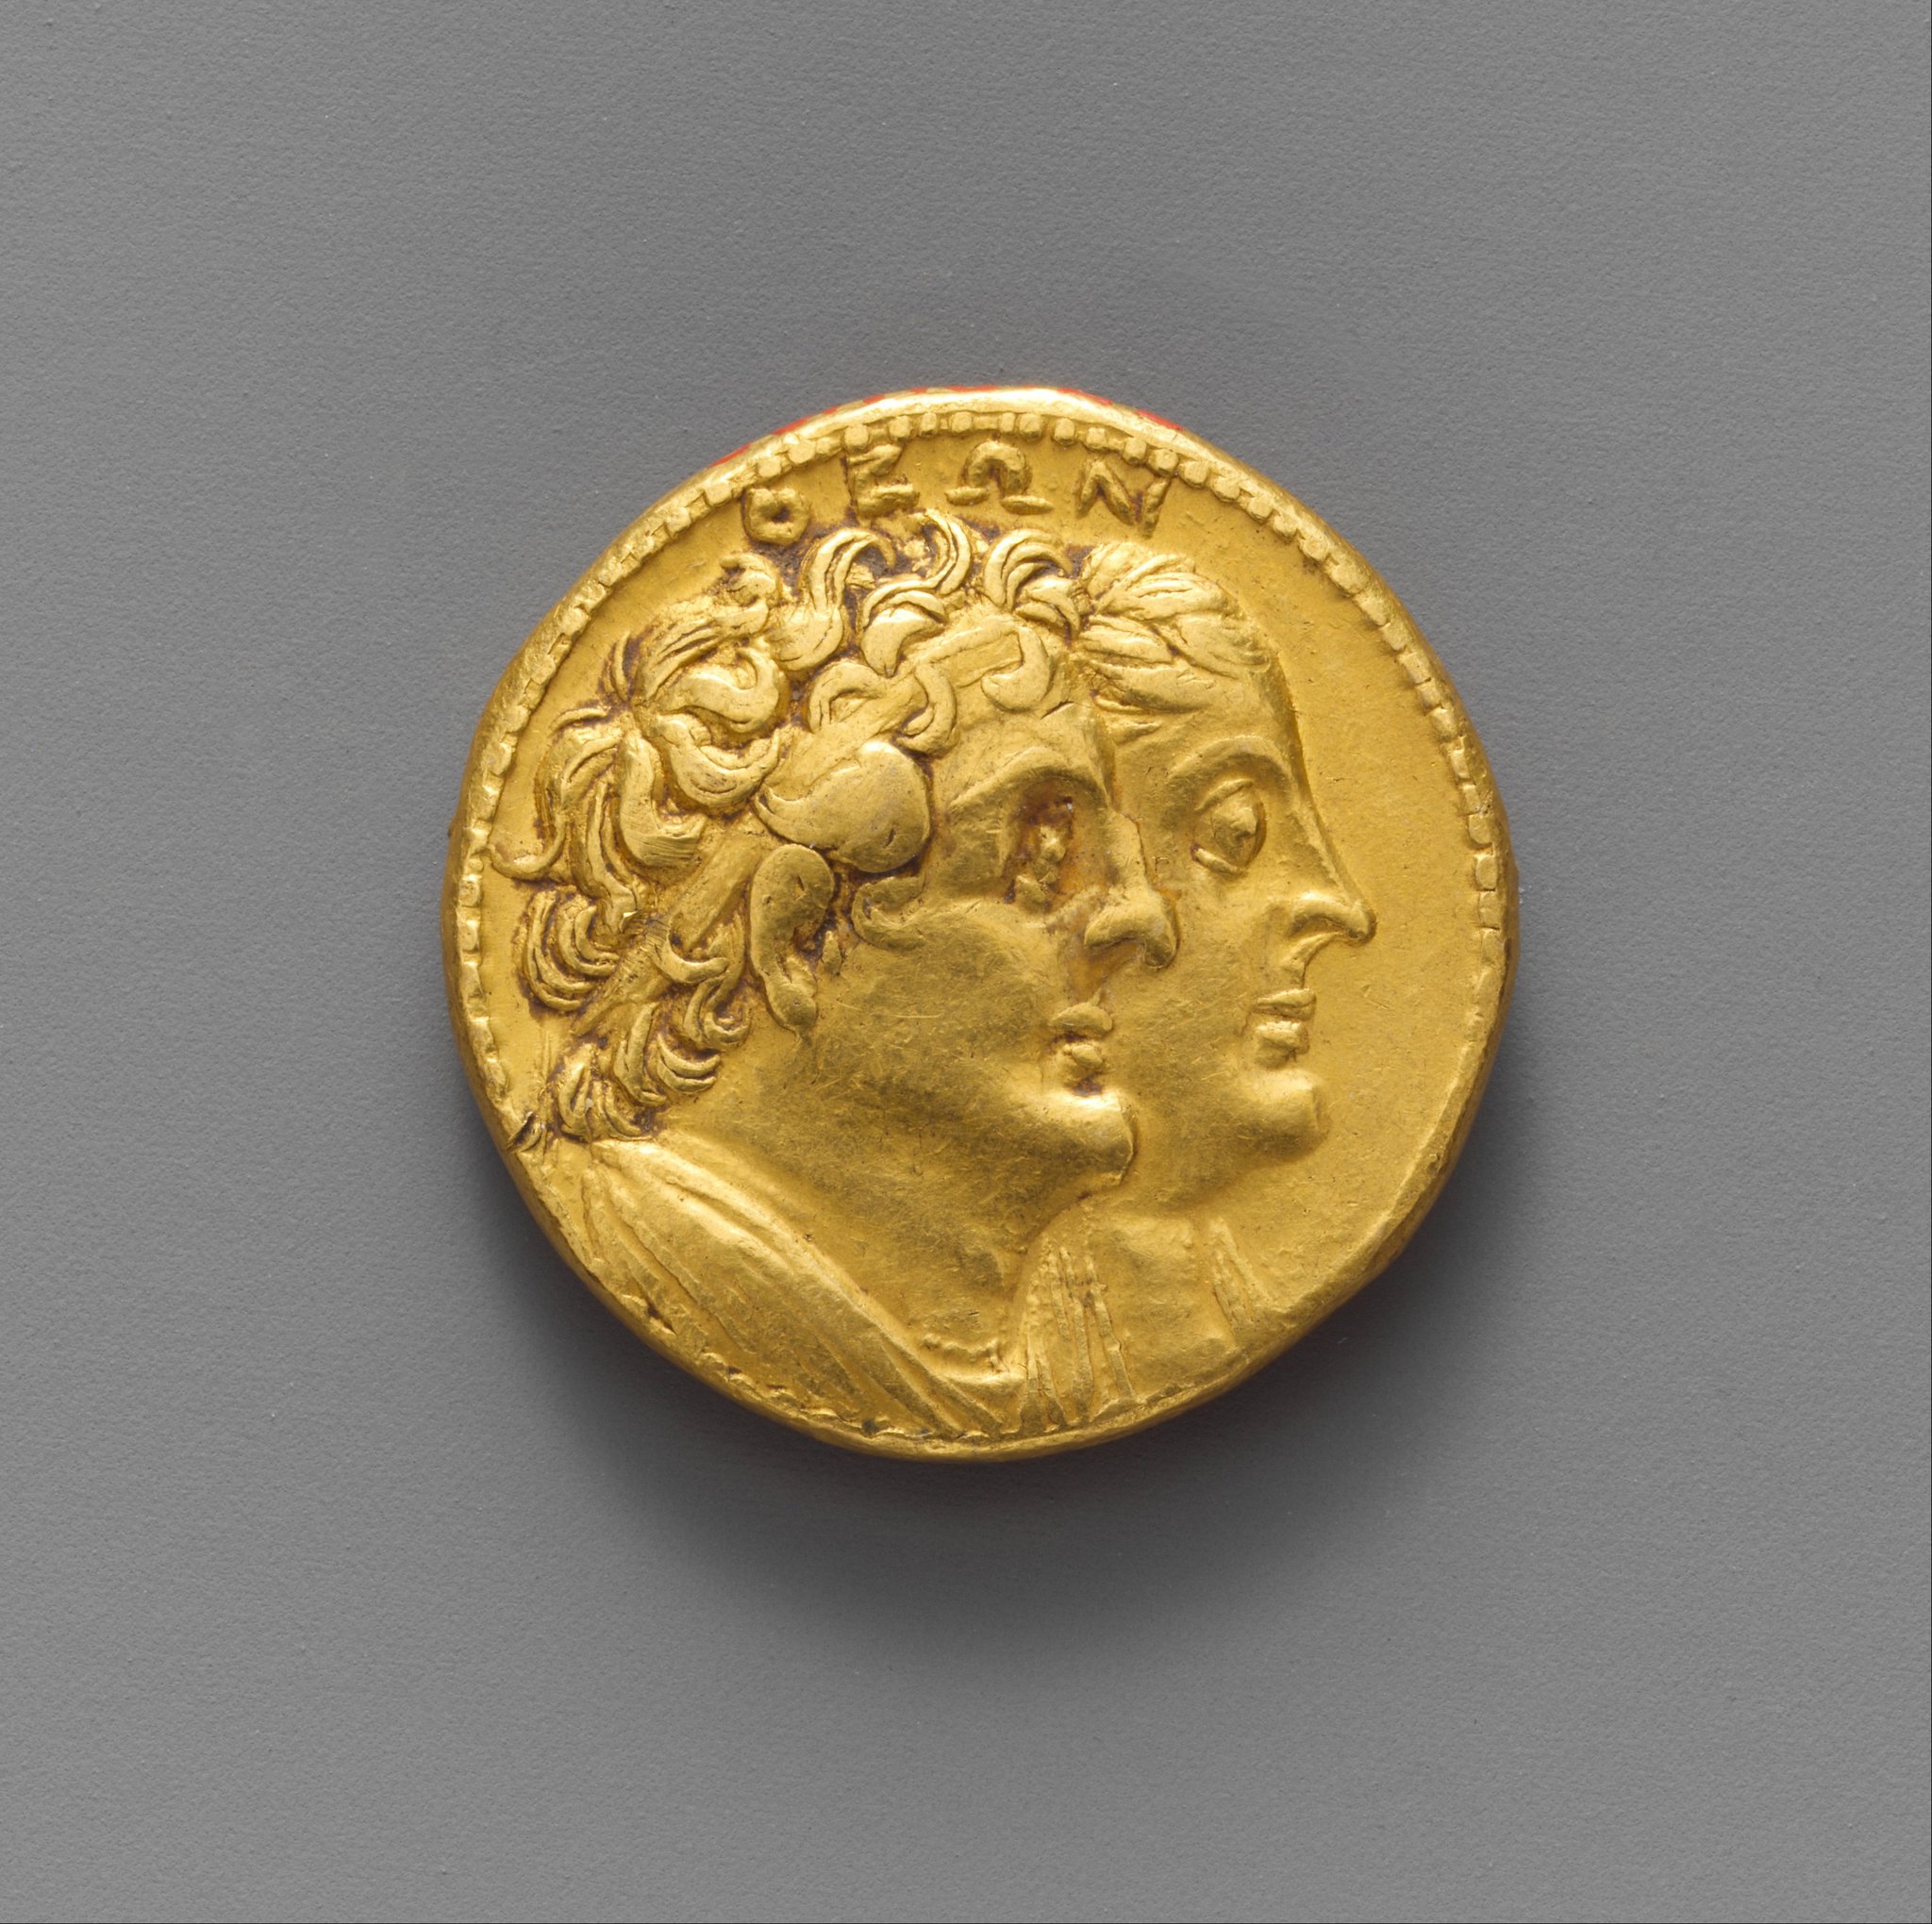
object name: oktadrachm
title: Gold oktadrachm of Ptolemy III Euergetes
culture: greek, ptolemaic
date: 246-221 BCE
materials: gold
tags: men,profiles